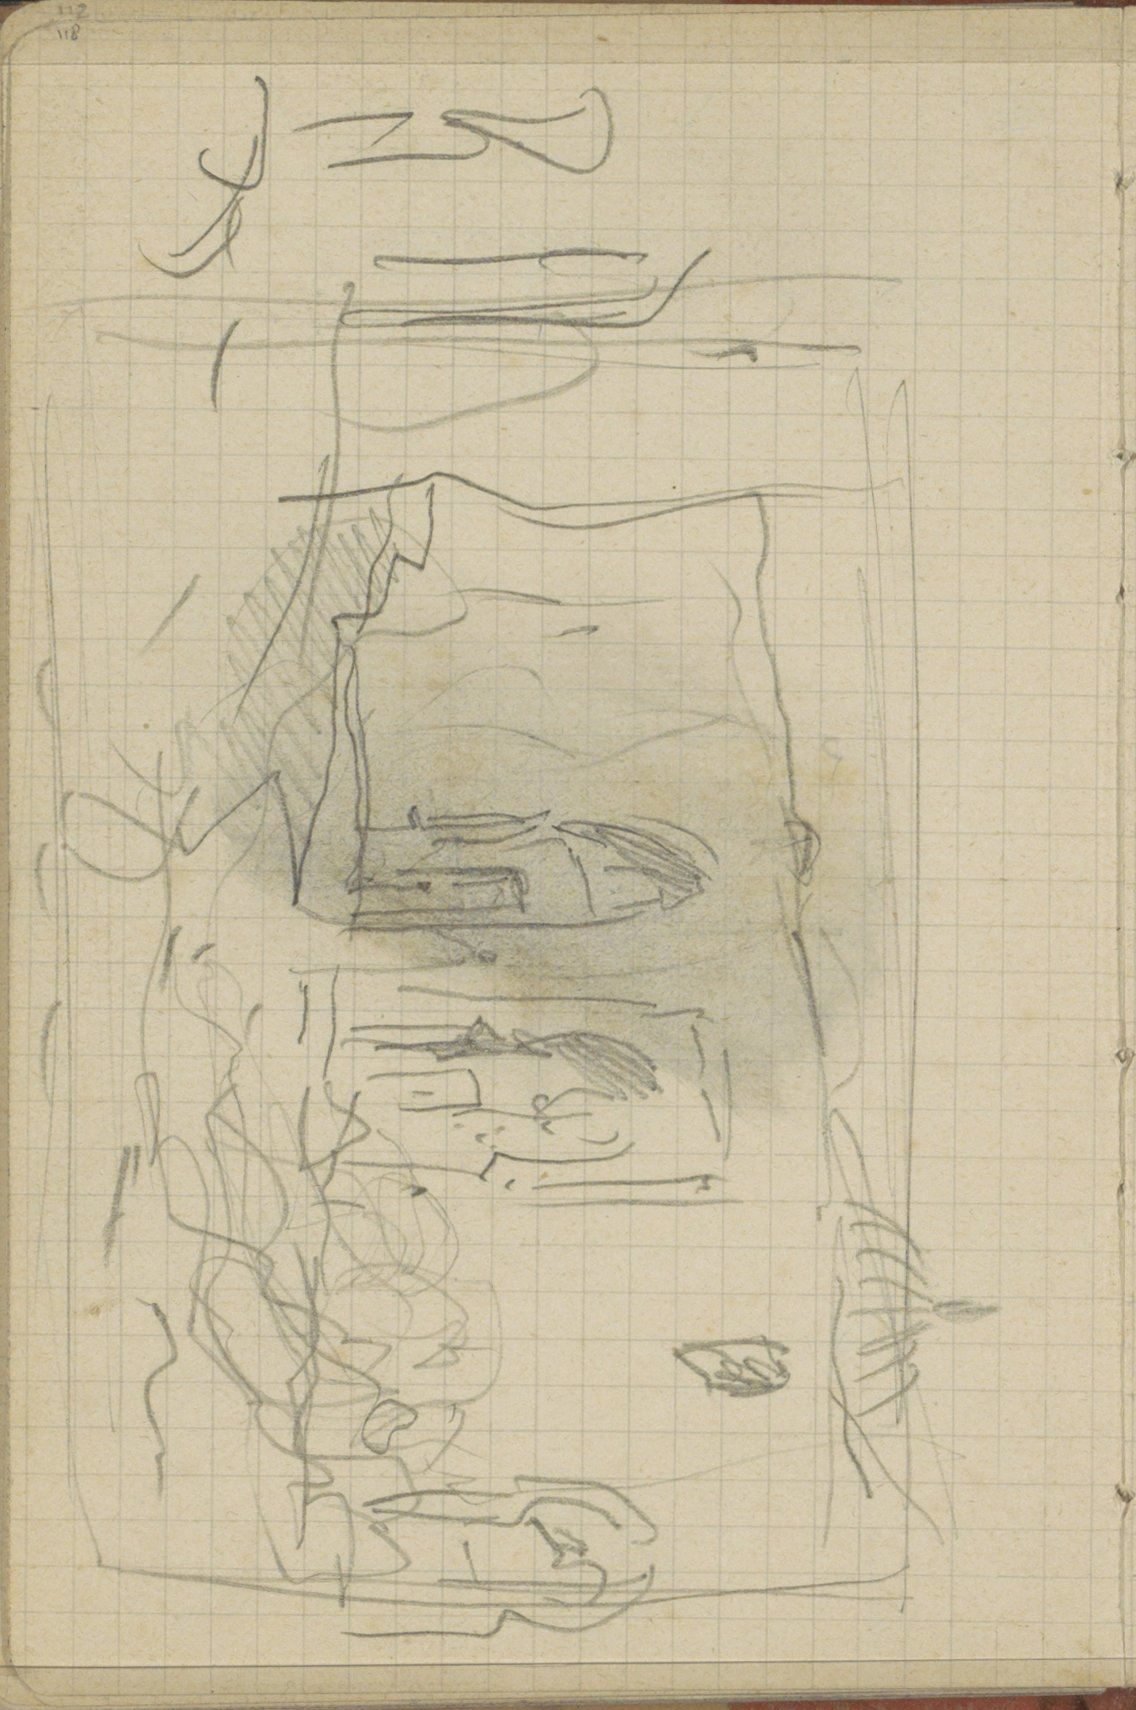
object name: sketchbook leaf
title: Straatgezicht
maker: marius bauer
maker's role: draughtsman, print maker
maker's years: 1867-1932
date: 1909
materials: pencil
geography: tunisia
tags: street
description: Pagina 118 uit een schetsboek met 67 bladen.